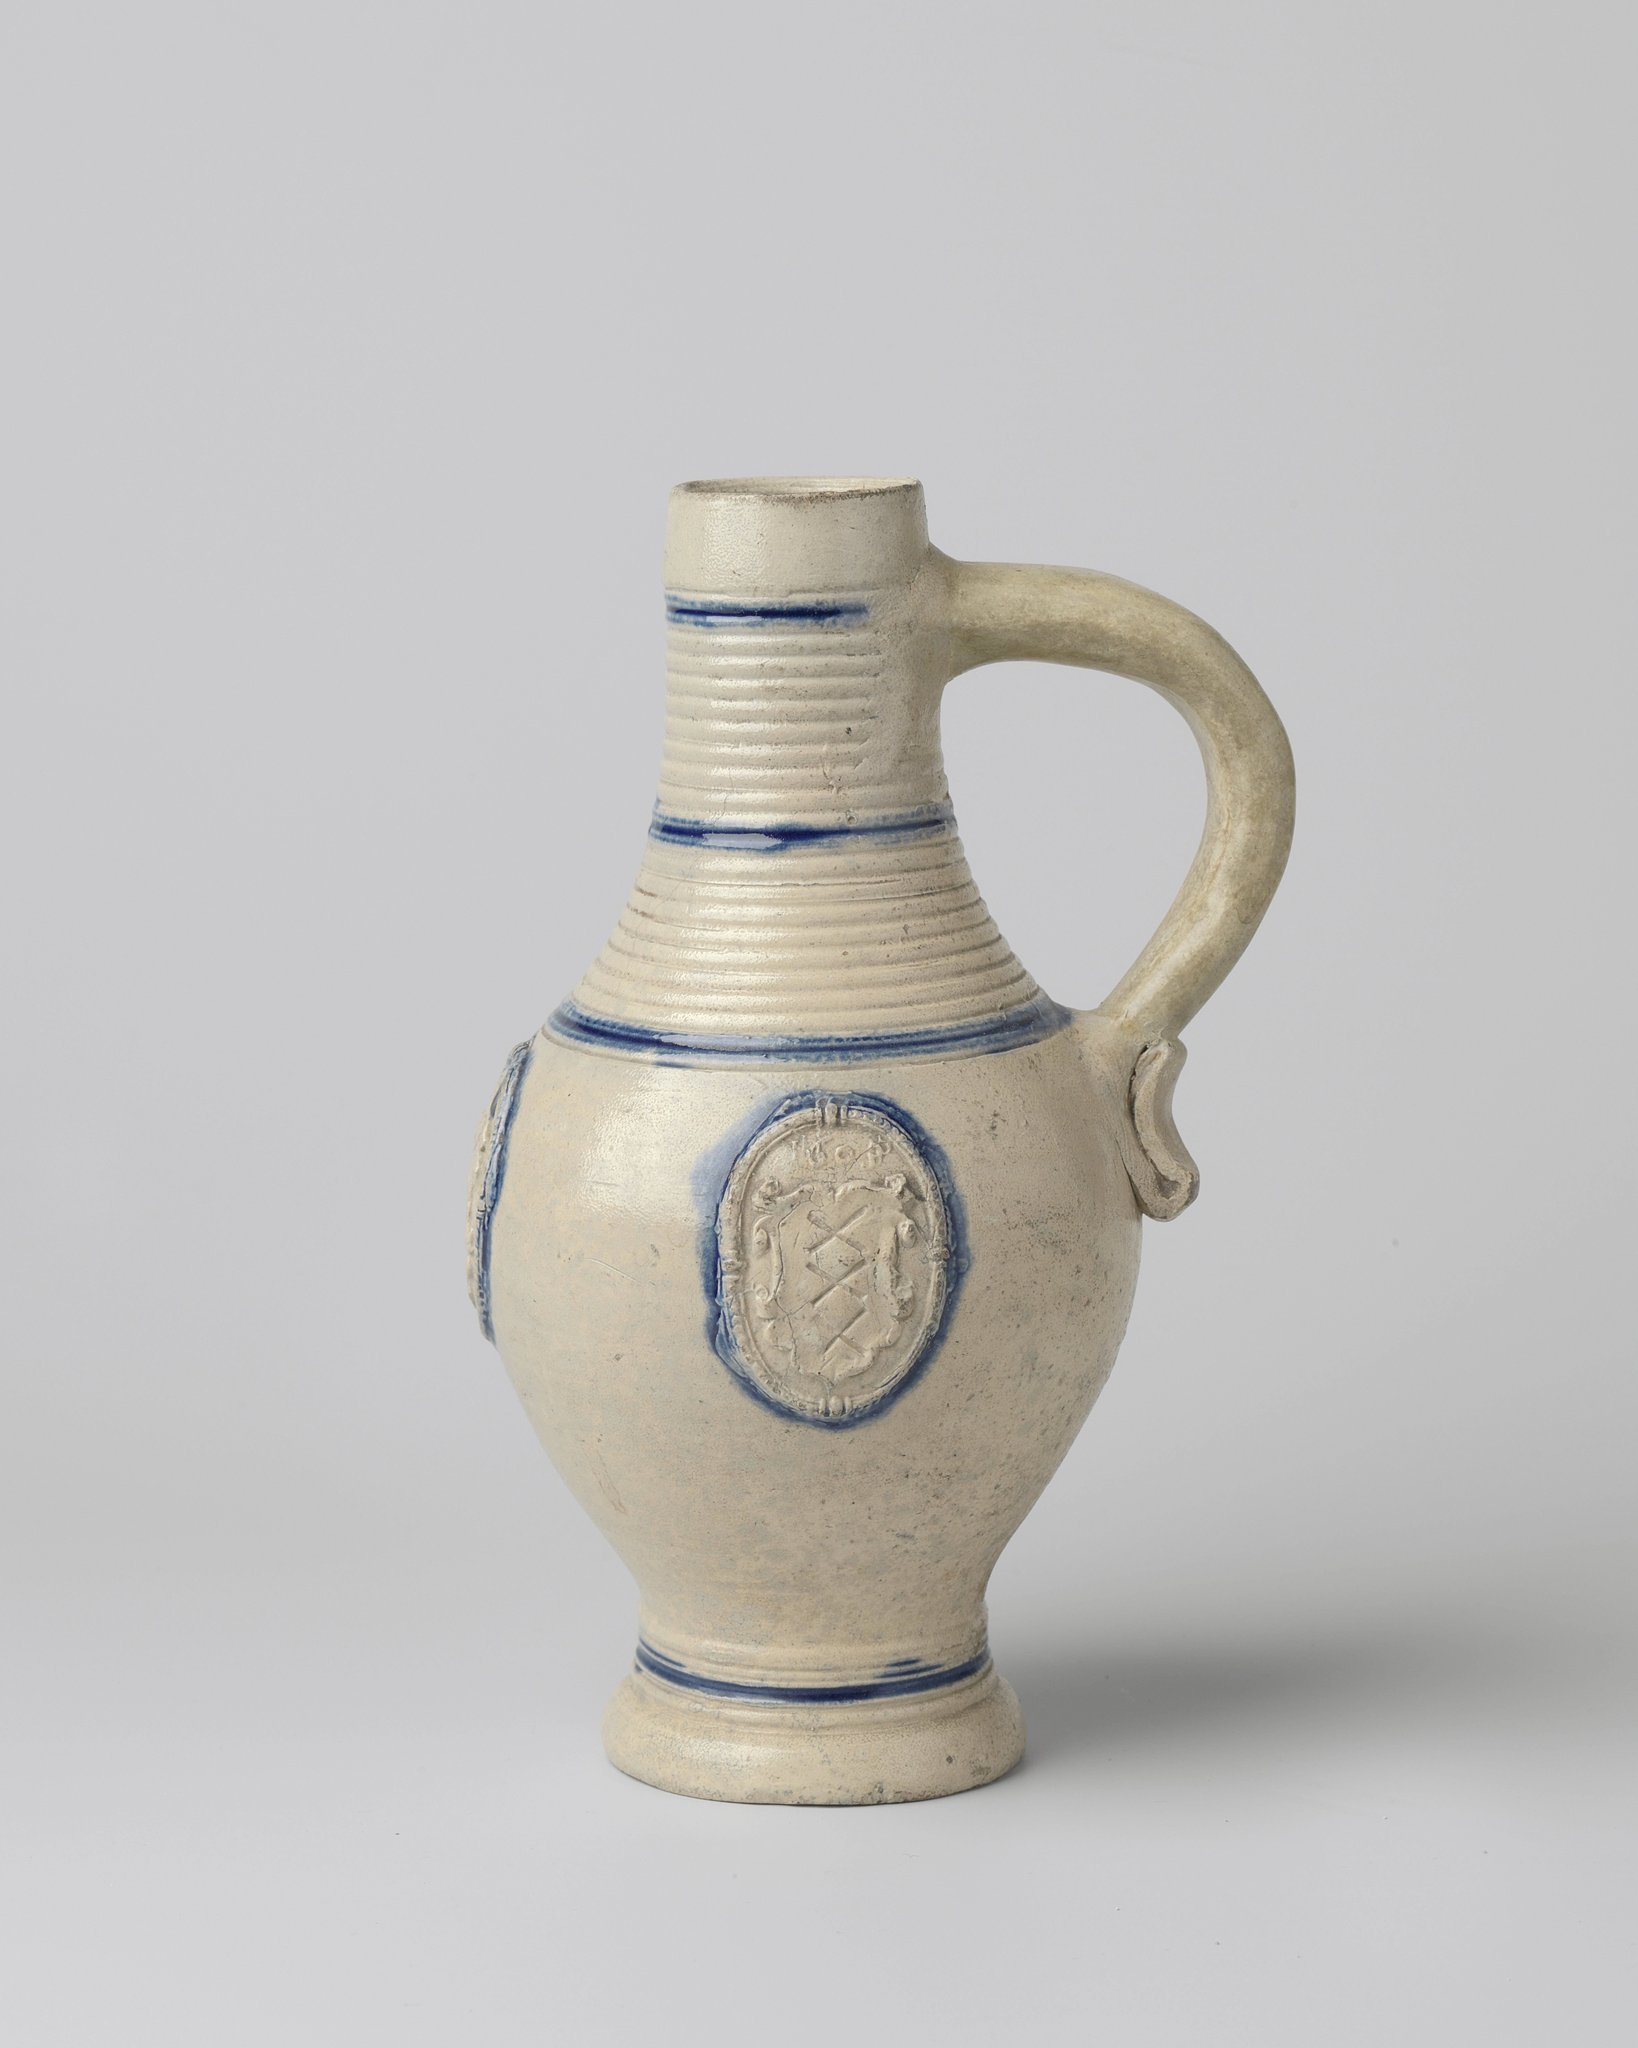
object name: jug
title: Jug with the coat of arms of Amsterdam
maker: Anonymous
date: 1603-1649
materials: cobalt, glaze, stoneware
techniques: firing, forming, relief, turning, vitrification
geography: westerwald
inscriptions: inscription: ‘4[?] KW VT’, date: ‘1603’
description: Kruik van steengoed op hoge voet met een eivormig lichaam en een taps toelopende nek. Het C-vormige oor is bevestigd aan de nek en de schouder. Een brede band met ingegrifte lijnen op de nek, enkele op de voet. Gedeeltelijk bedekt met kobaltblauw. Op de buik tweemaal een gedrukt en opgelegd medaillon met het wapen van Amsterdam in reliëf. Het derde wapen met het opschrift '1603' en kruislings letters op een schild '4[?] KW VT'. Westerwald.